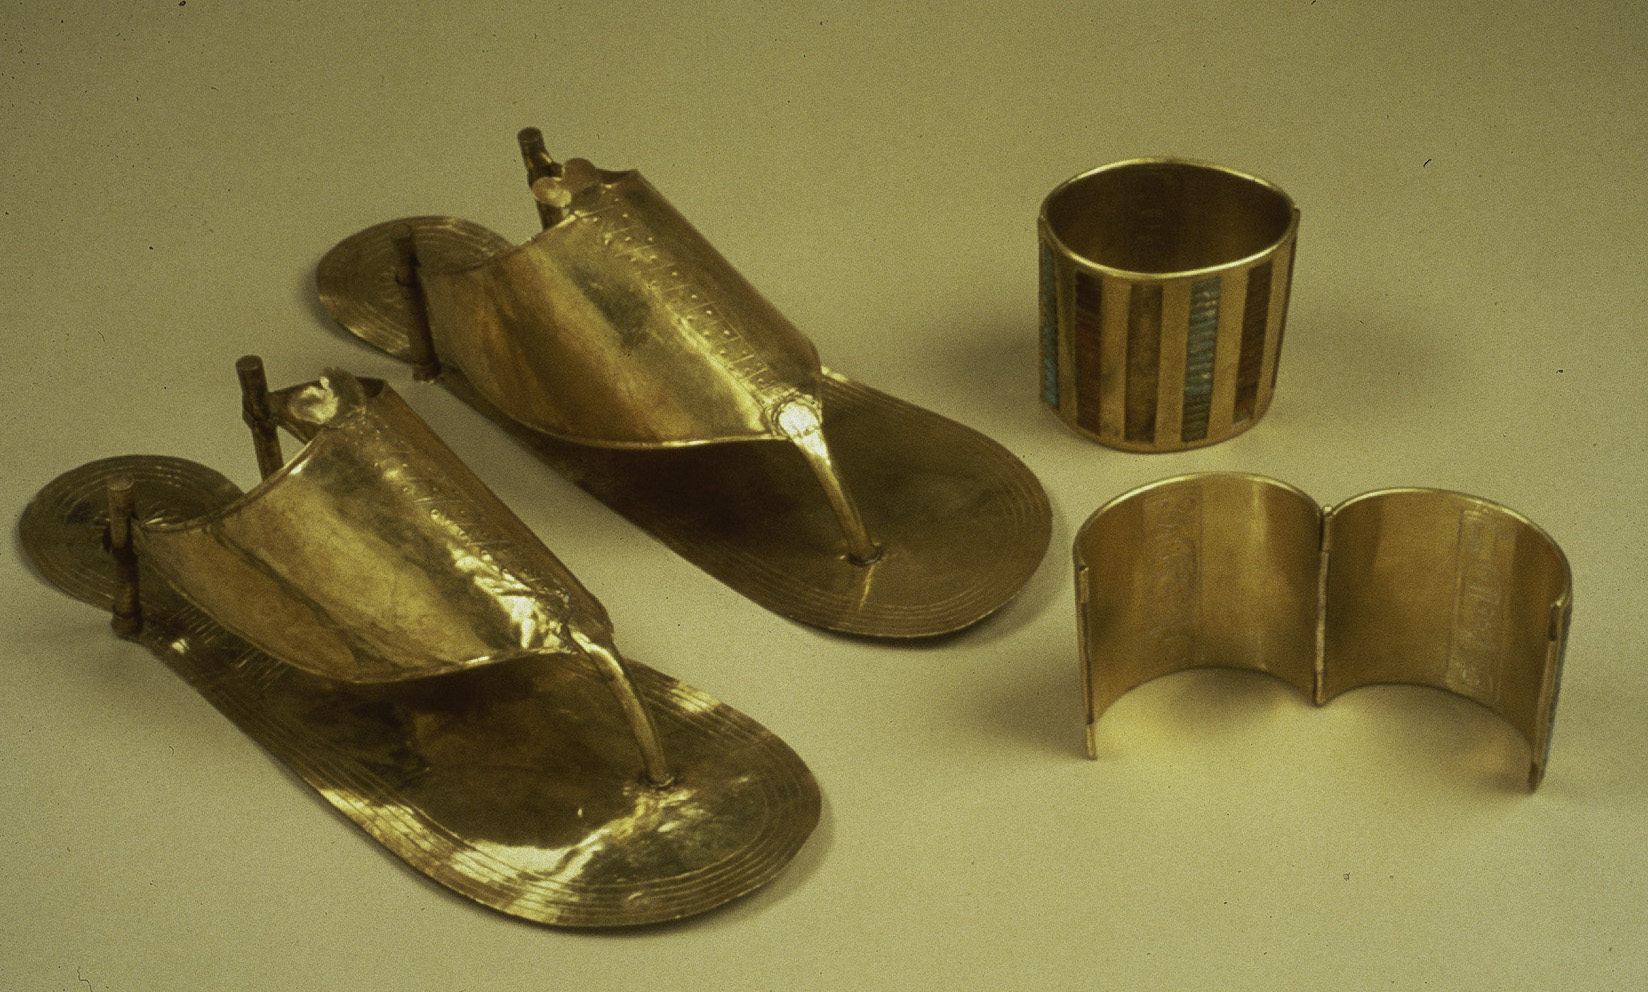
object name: pair of funerary sandal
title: Sandals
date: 1479-1425 BCE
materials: gold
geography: egypt